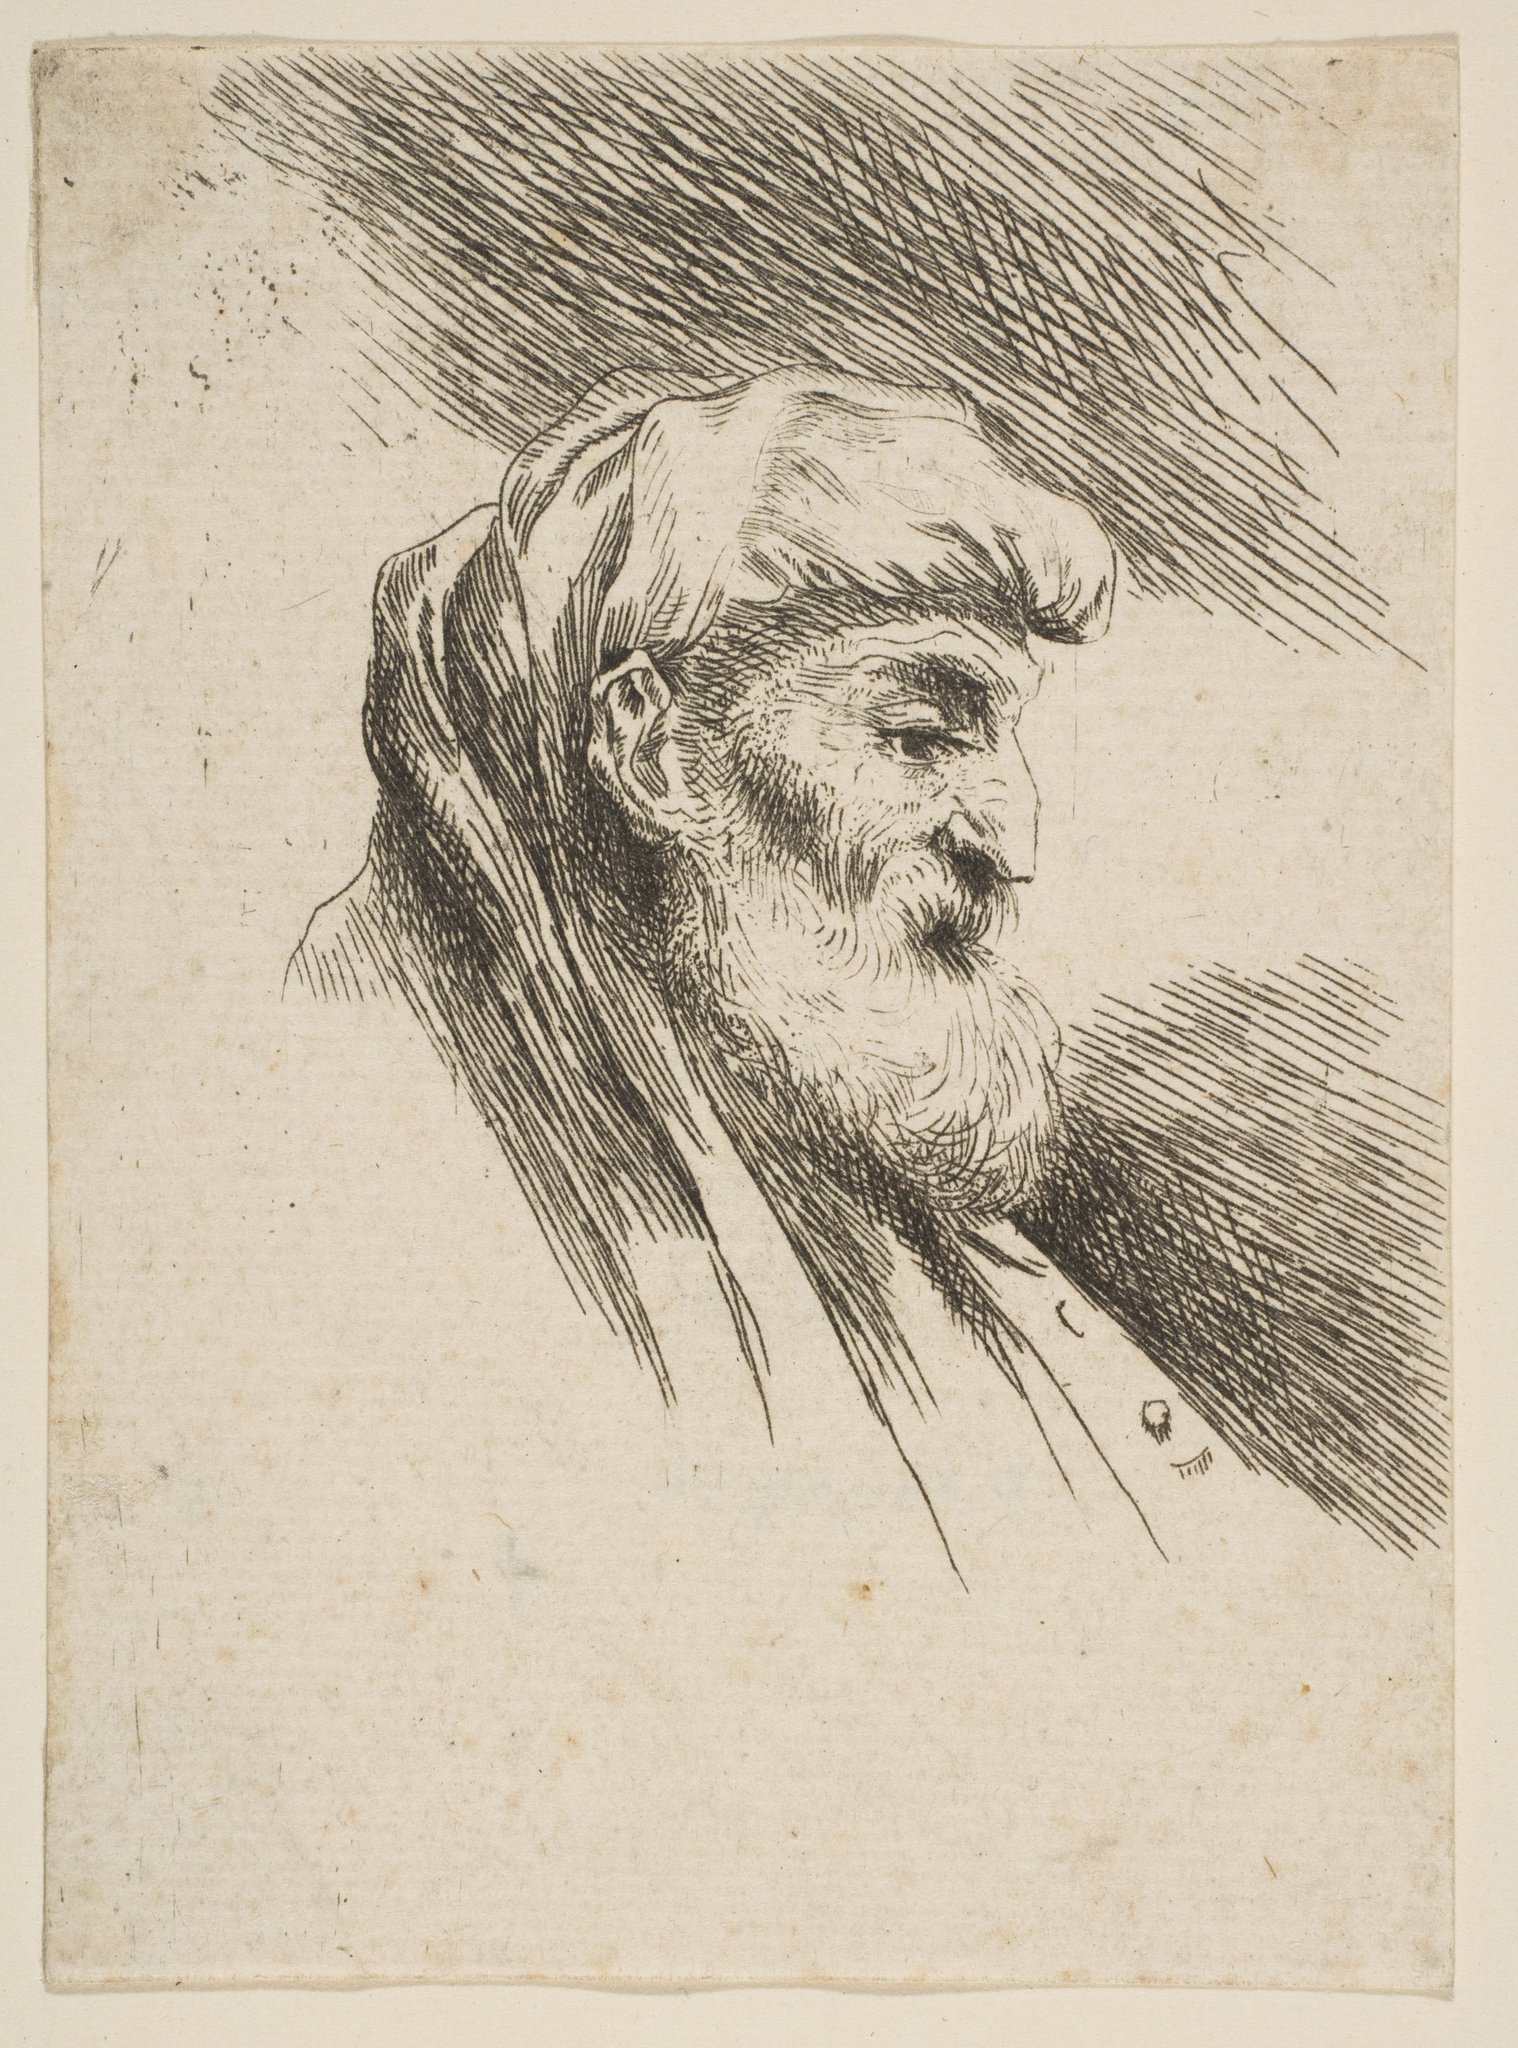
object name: print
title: Head of an old bearded man facing right, from the series of 'Small Heads in Oriental Headdress'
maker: giovanni benedetto castiglione (il grechetto)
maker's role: artist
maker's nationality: italian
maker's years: 1609-1664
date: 1645-1650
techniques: etching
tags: men,profiles